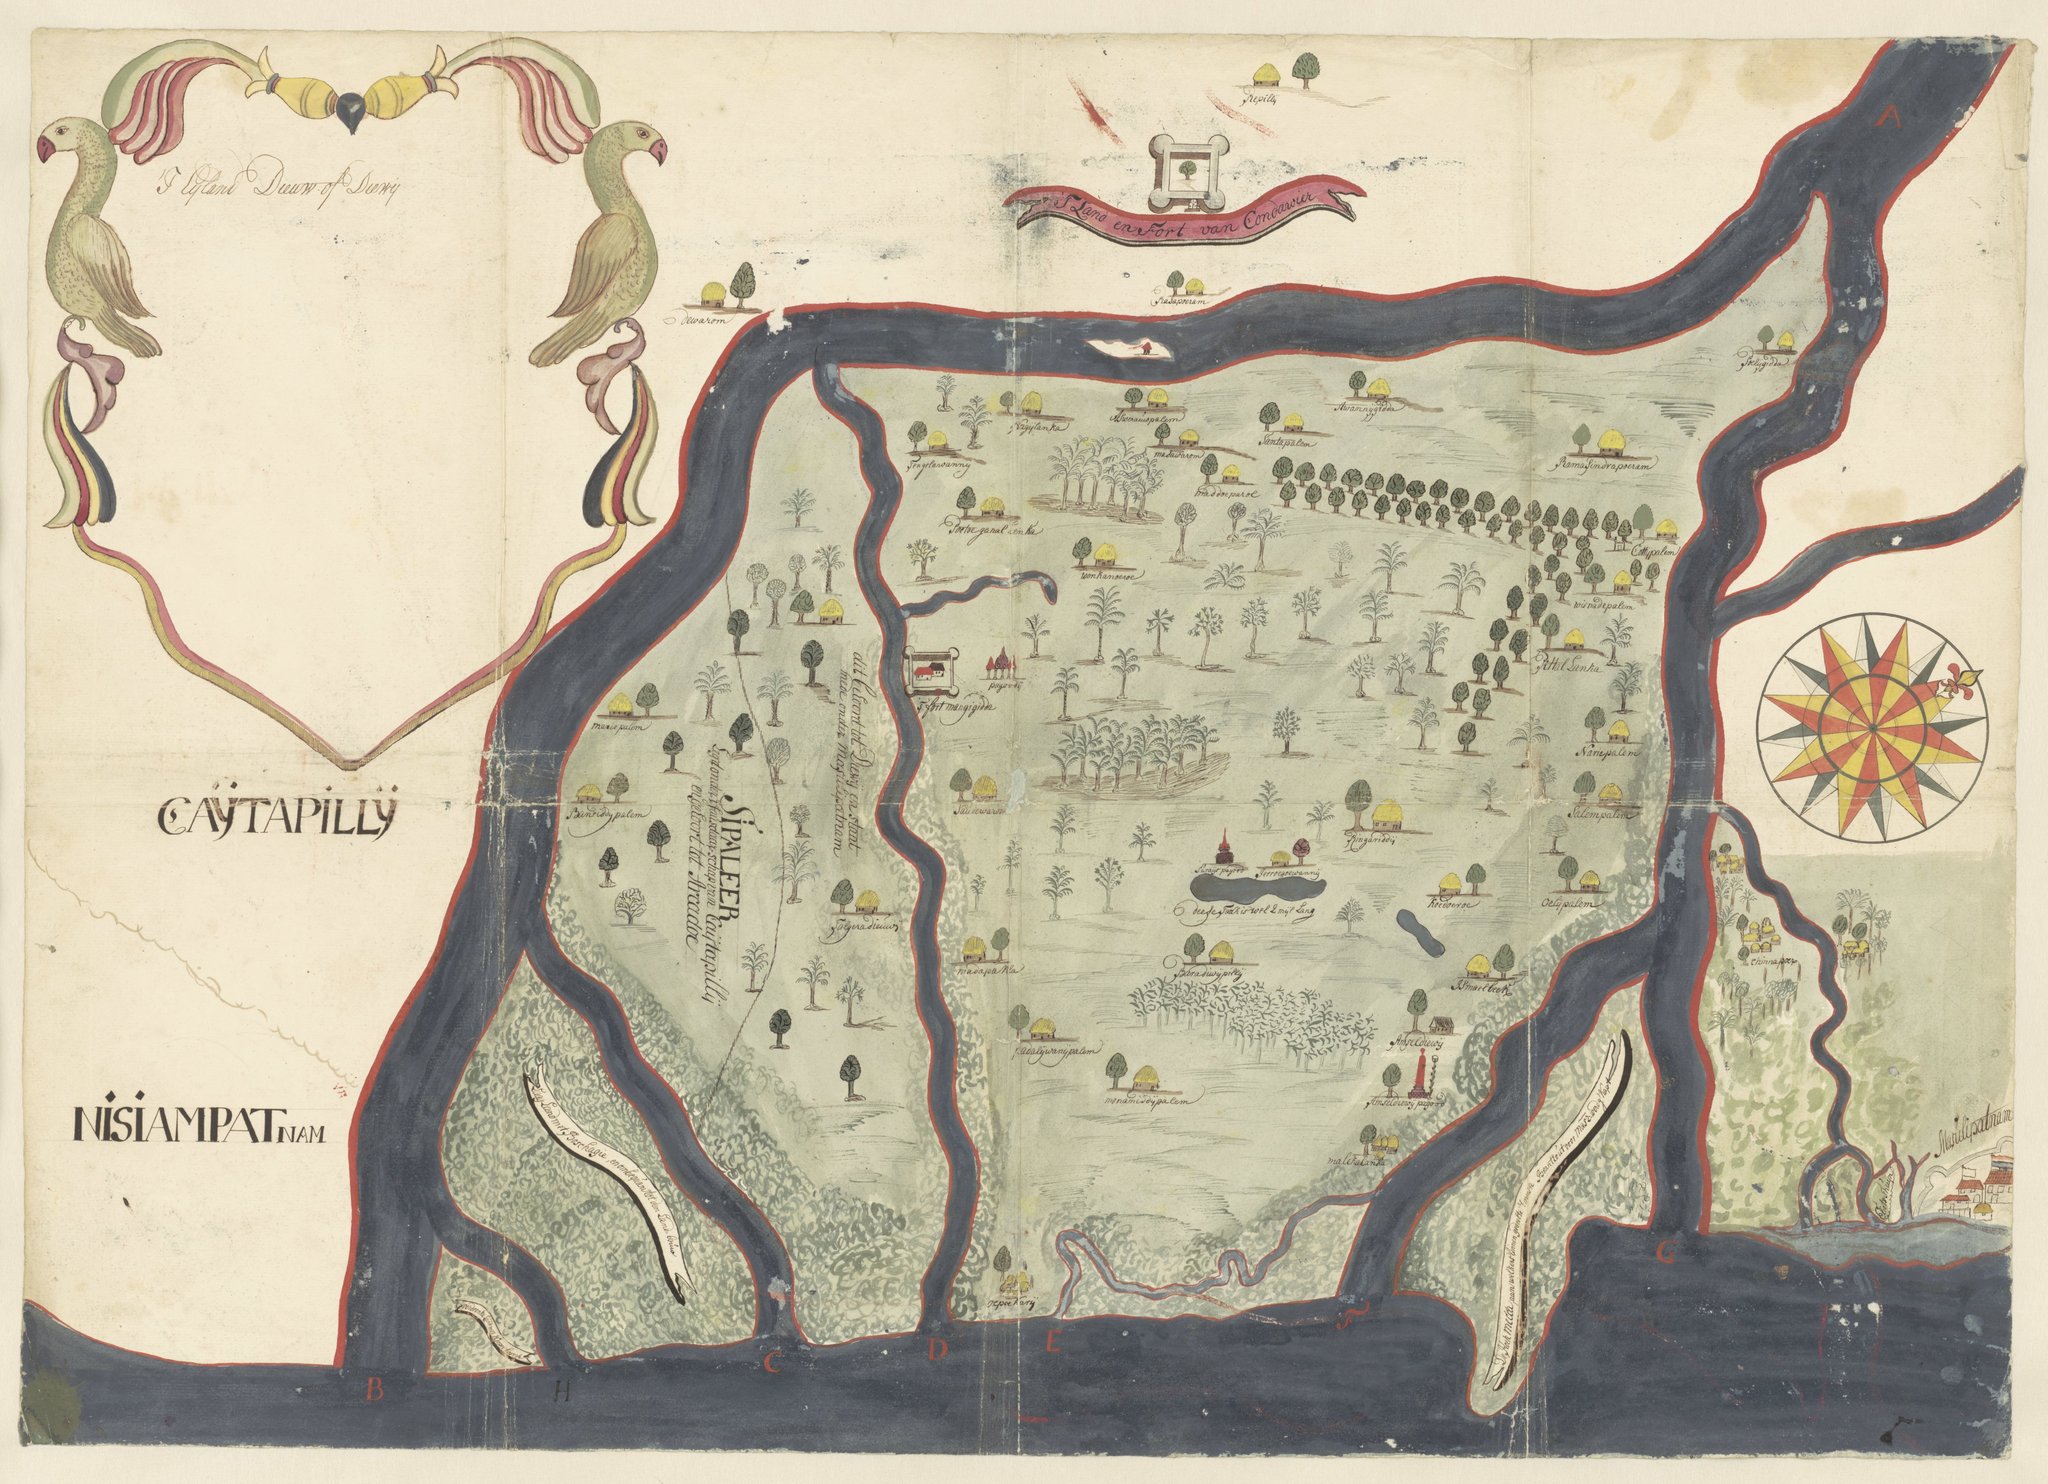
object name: area plan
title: Plattegrond van het eiland Dieuw of Diewij aan de Koromandelkust, India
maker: Anonymous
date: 1675-1725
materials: gouache, ink, paint, paper, watercolor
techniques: drawing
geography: deccan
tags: adrianus canter visscher, maps of separate countries or regions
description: Plattegrond van het eiland Dieuw of Dieuwij aan de Koromandelkust, India, met daarop een rivierdelta en verschillende nederzettingen met namen.